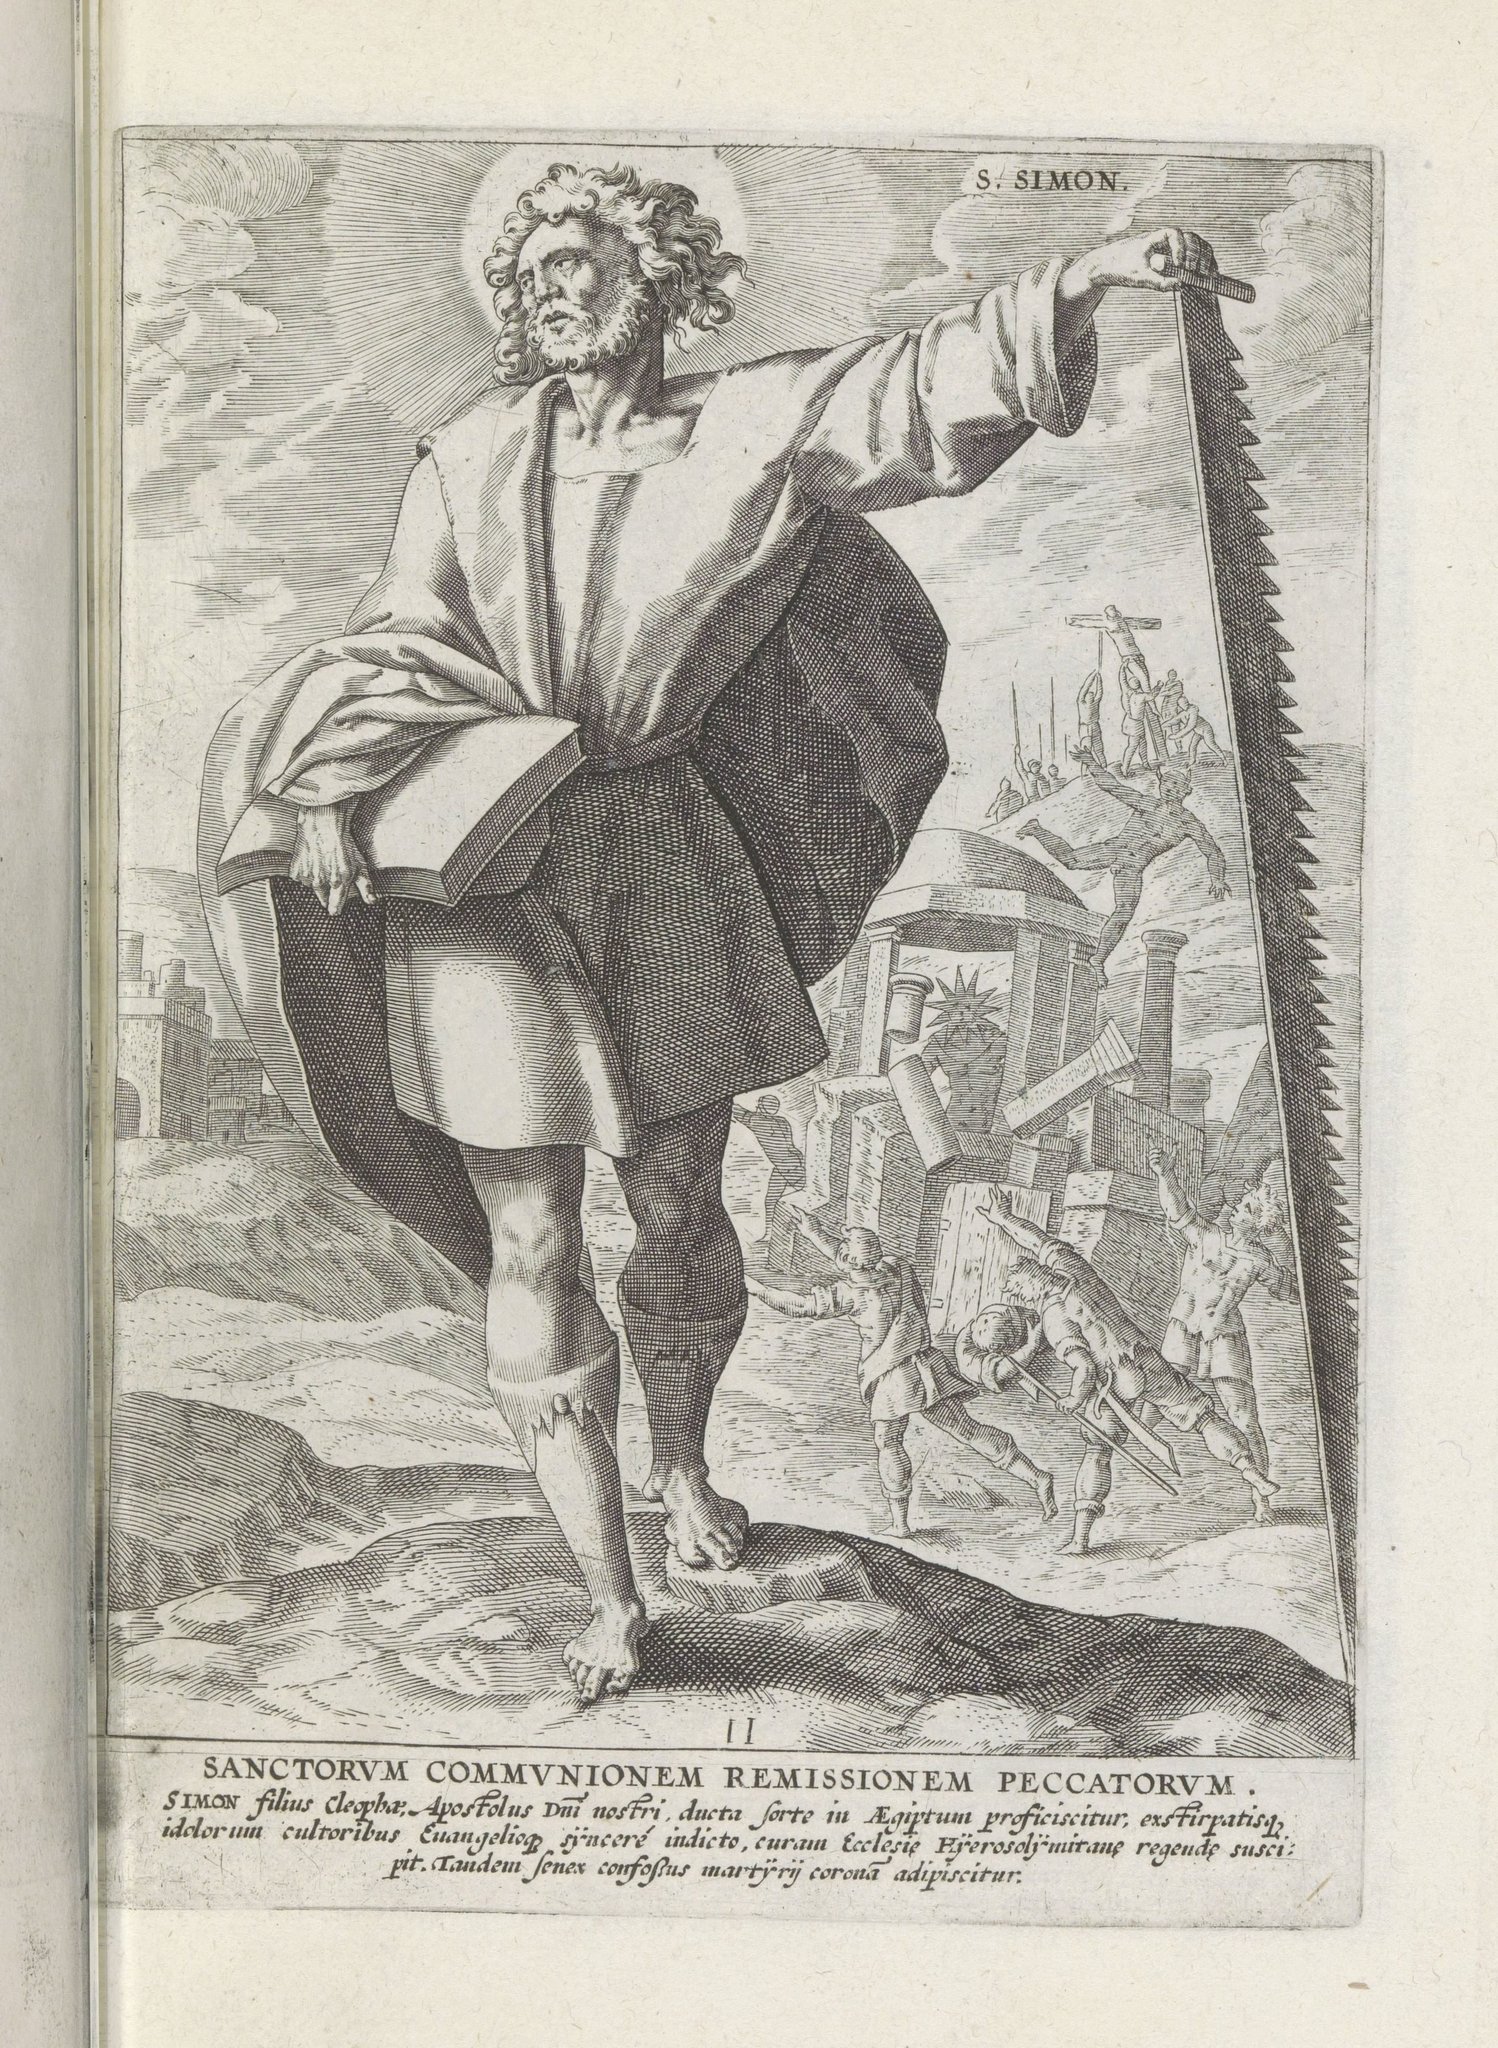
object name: print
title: Thesaurus novi Testamenti elegantissimis iconibus expressus continens historias atque miracula doni nostri Iesu Christi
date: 1585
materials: paper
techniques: engraving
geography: antwerp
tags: the apostle simon zelotes (or simon the canaanite); possible attributes: book, saw, scroll, the apostle simon zelotes (or simon the canaanite); possible attributes: book, saw, scroll - martyrdom, suffering, misfortune, death of male saint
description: De apostel Simon staande met een zaag in de hand. Rechts op de achtergrond zijn kruisiging en het instorten van een heidense tempel. Onder de voorstelling een regel uit de apostolische geloofsbelijdenis en een drieregelige tekst over Simon in het Latijn. Deze prent maakt deel uit van een album.